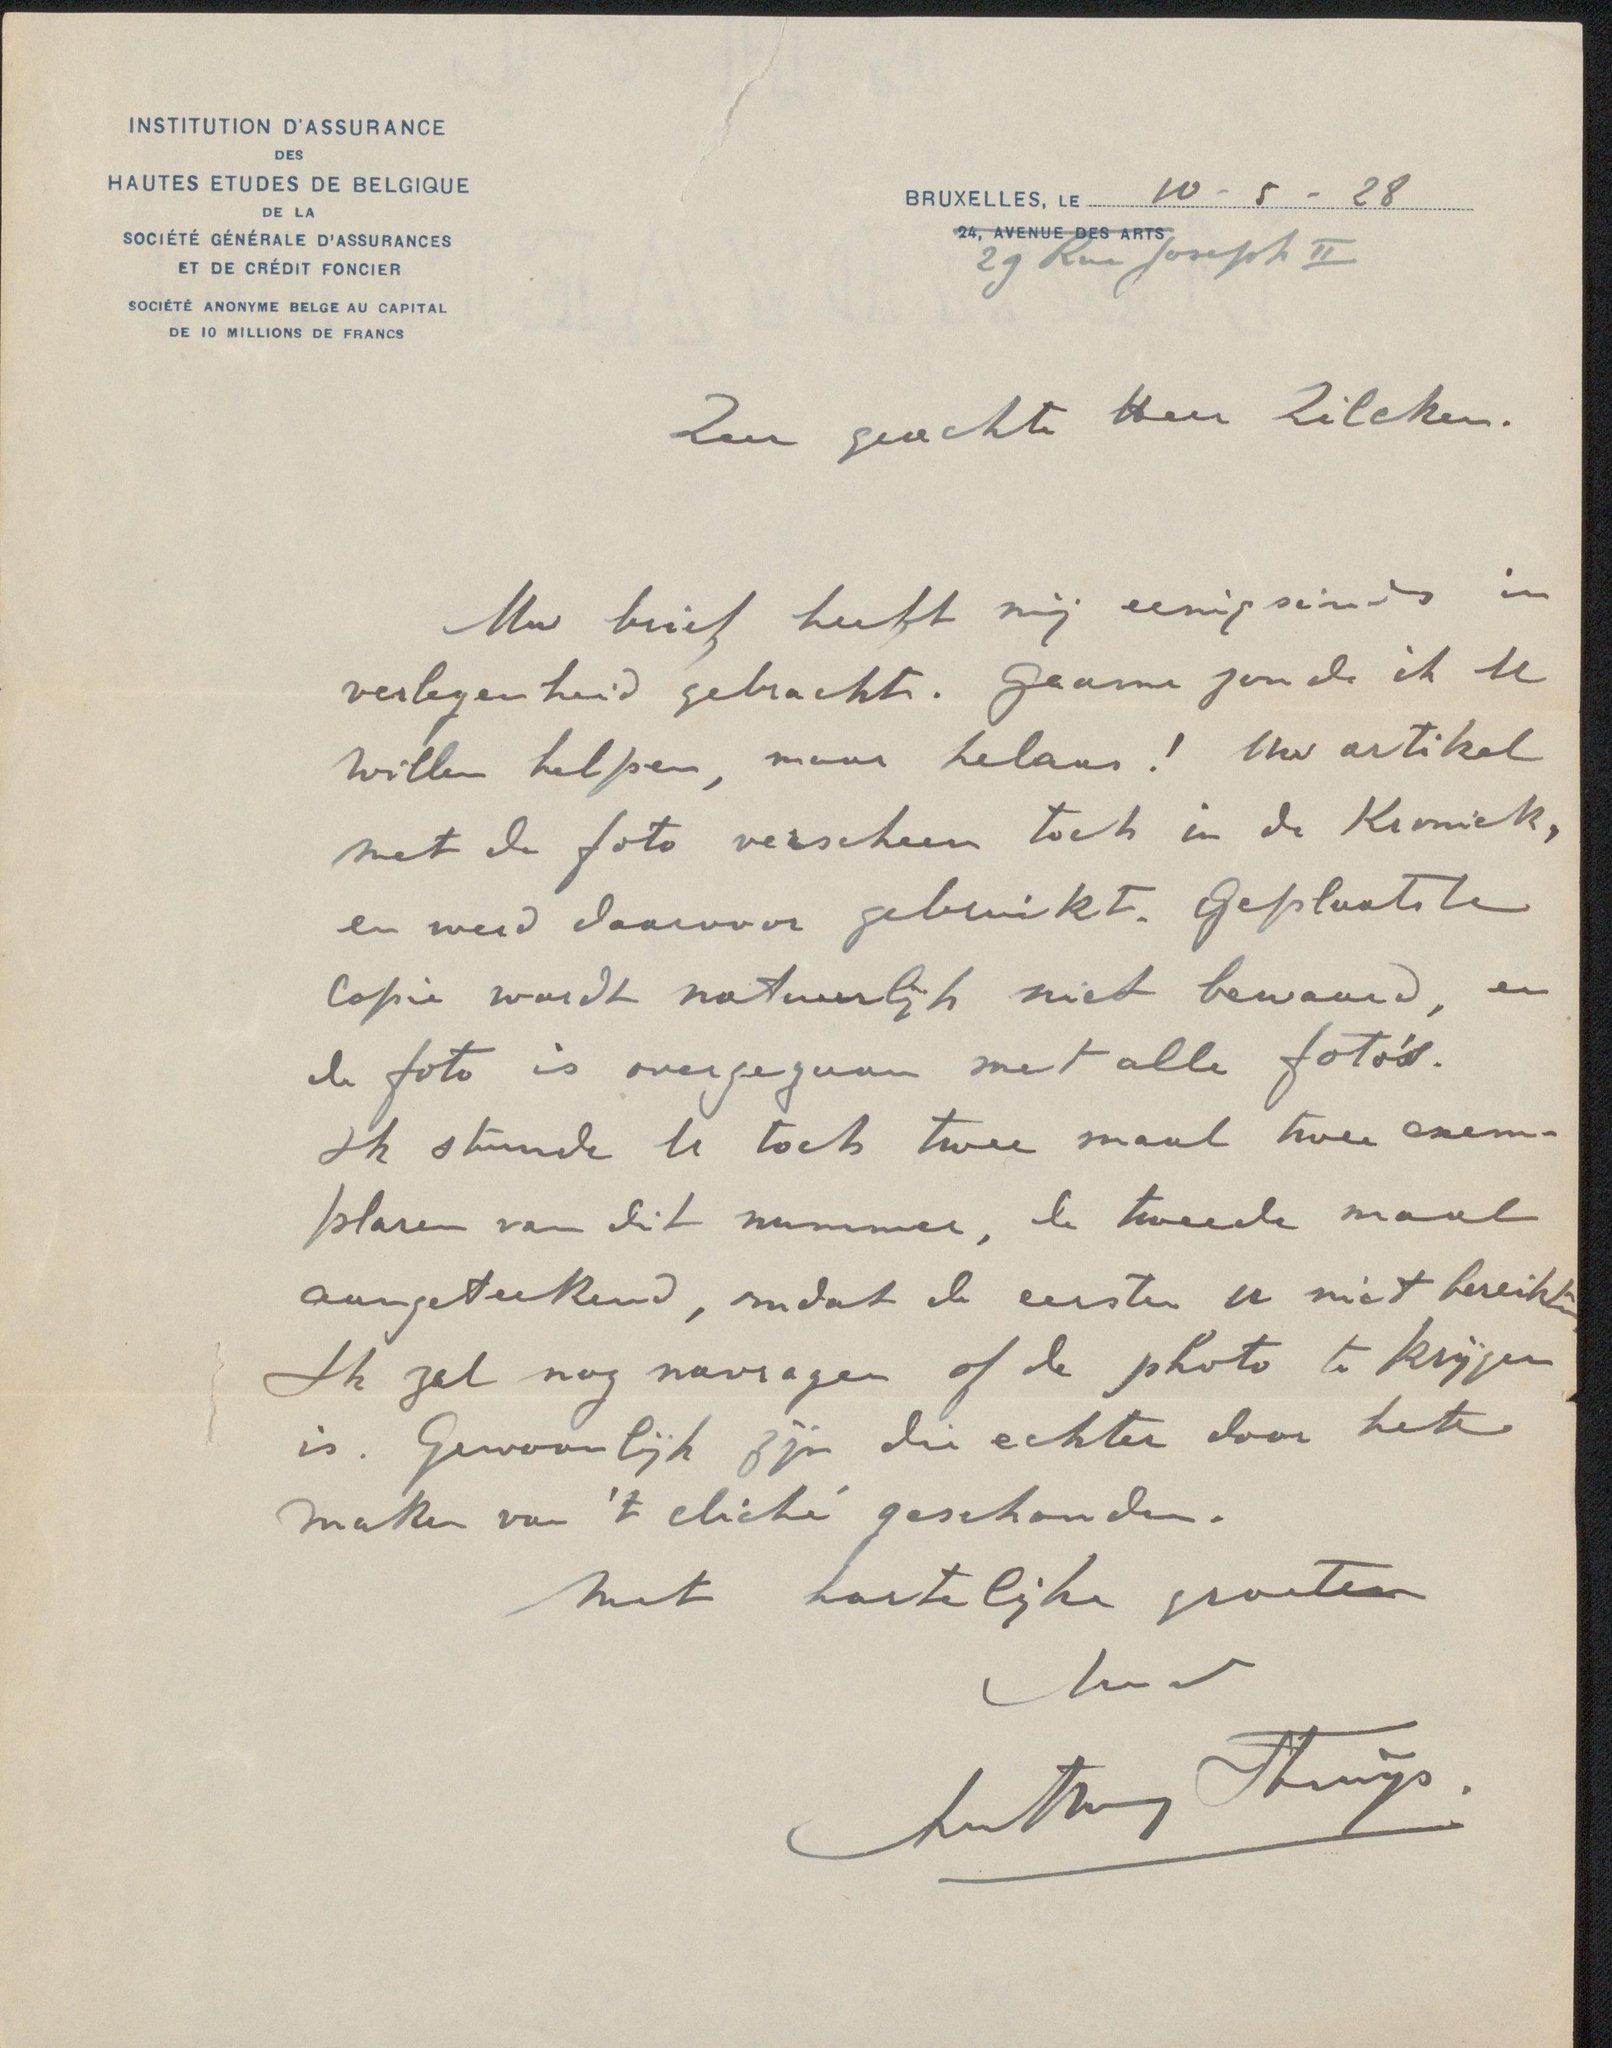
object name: letter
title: Brief aan Philip Zilcken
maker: anthony struys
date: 1928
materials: ink, paper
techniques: pen, printing, writing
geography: brussels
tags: painter, draughtsman, philip zilcken, photography, cinematography, printed matter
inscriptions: collector's mark: ‘RPK’